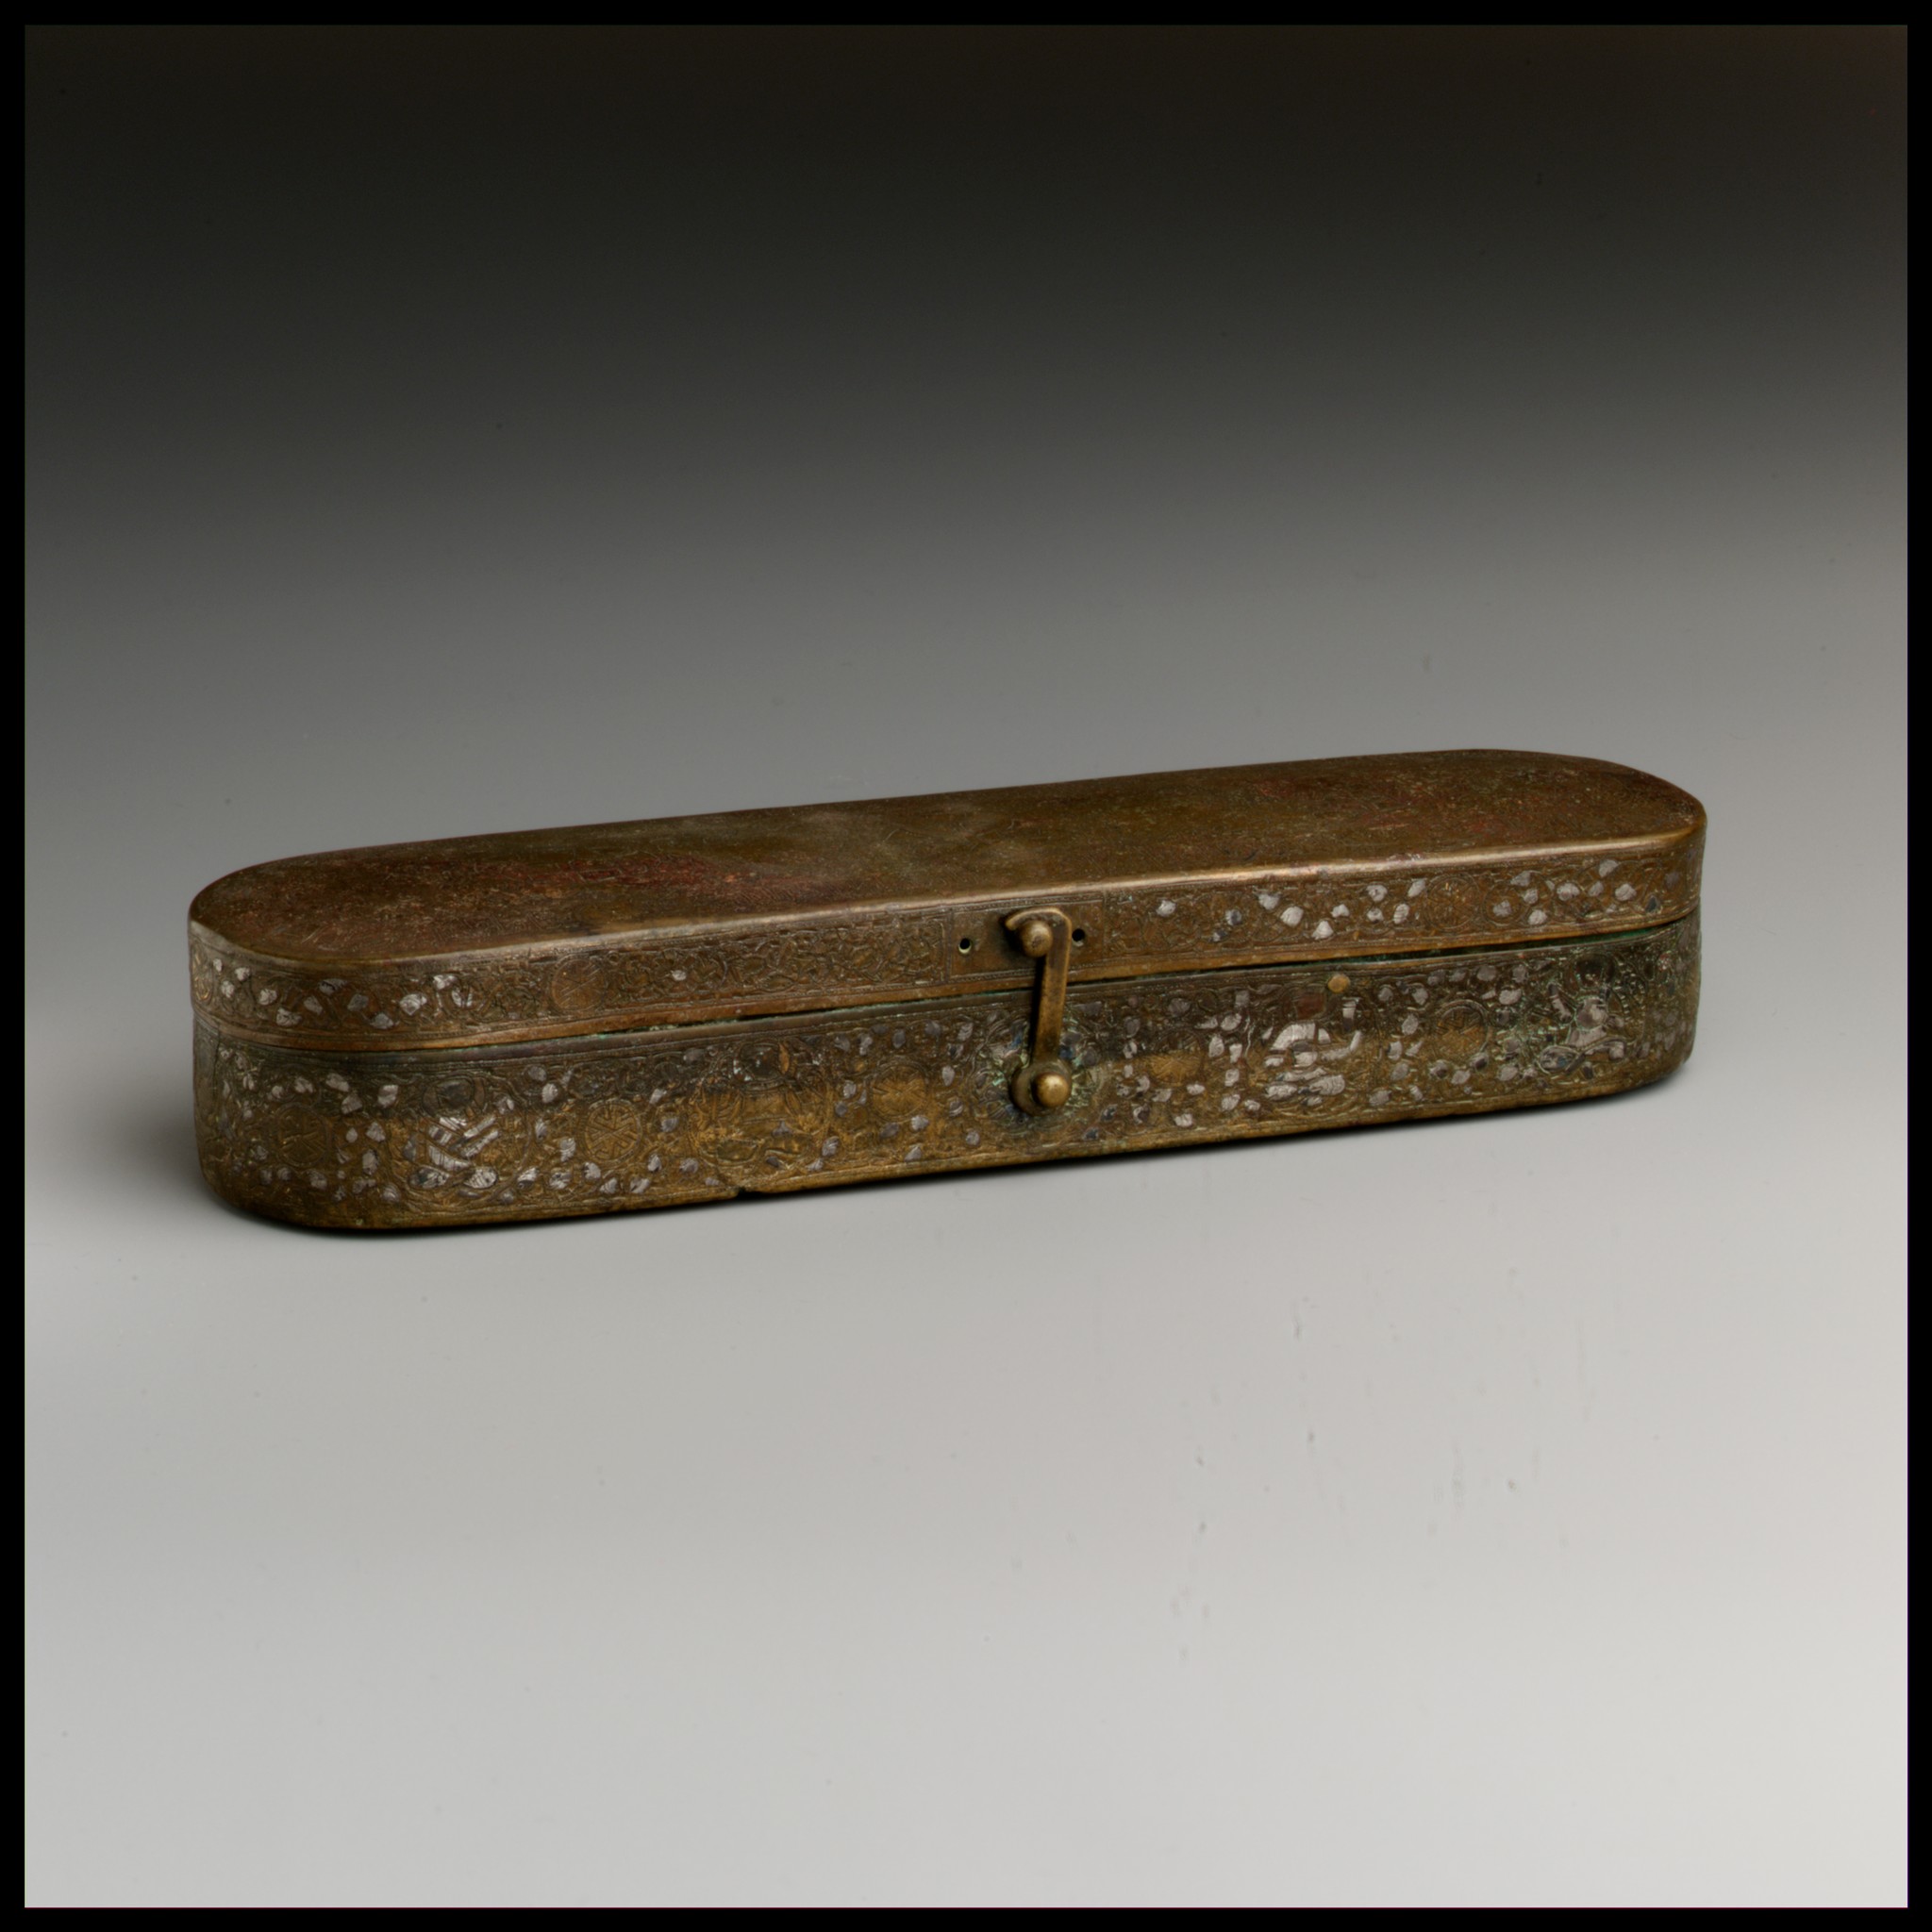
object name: pen box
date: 1201-1300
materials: brass, silver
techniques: engraving, incising, inlay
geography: iraq